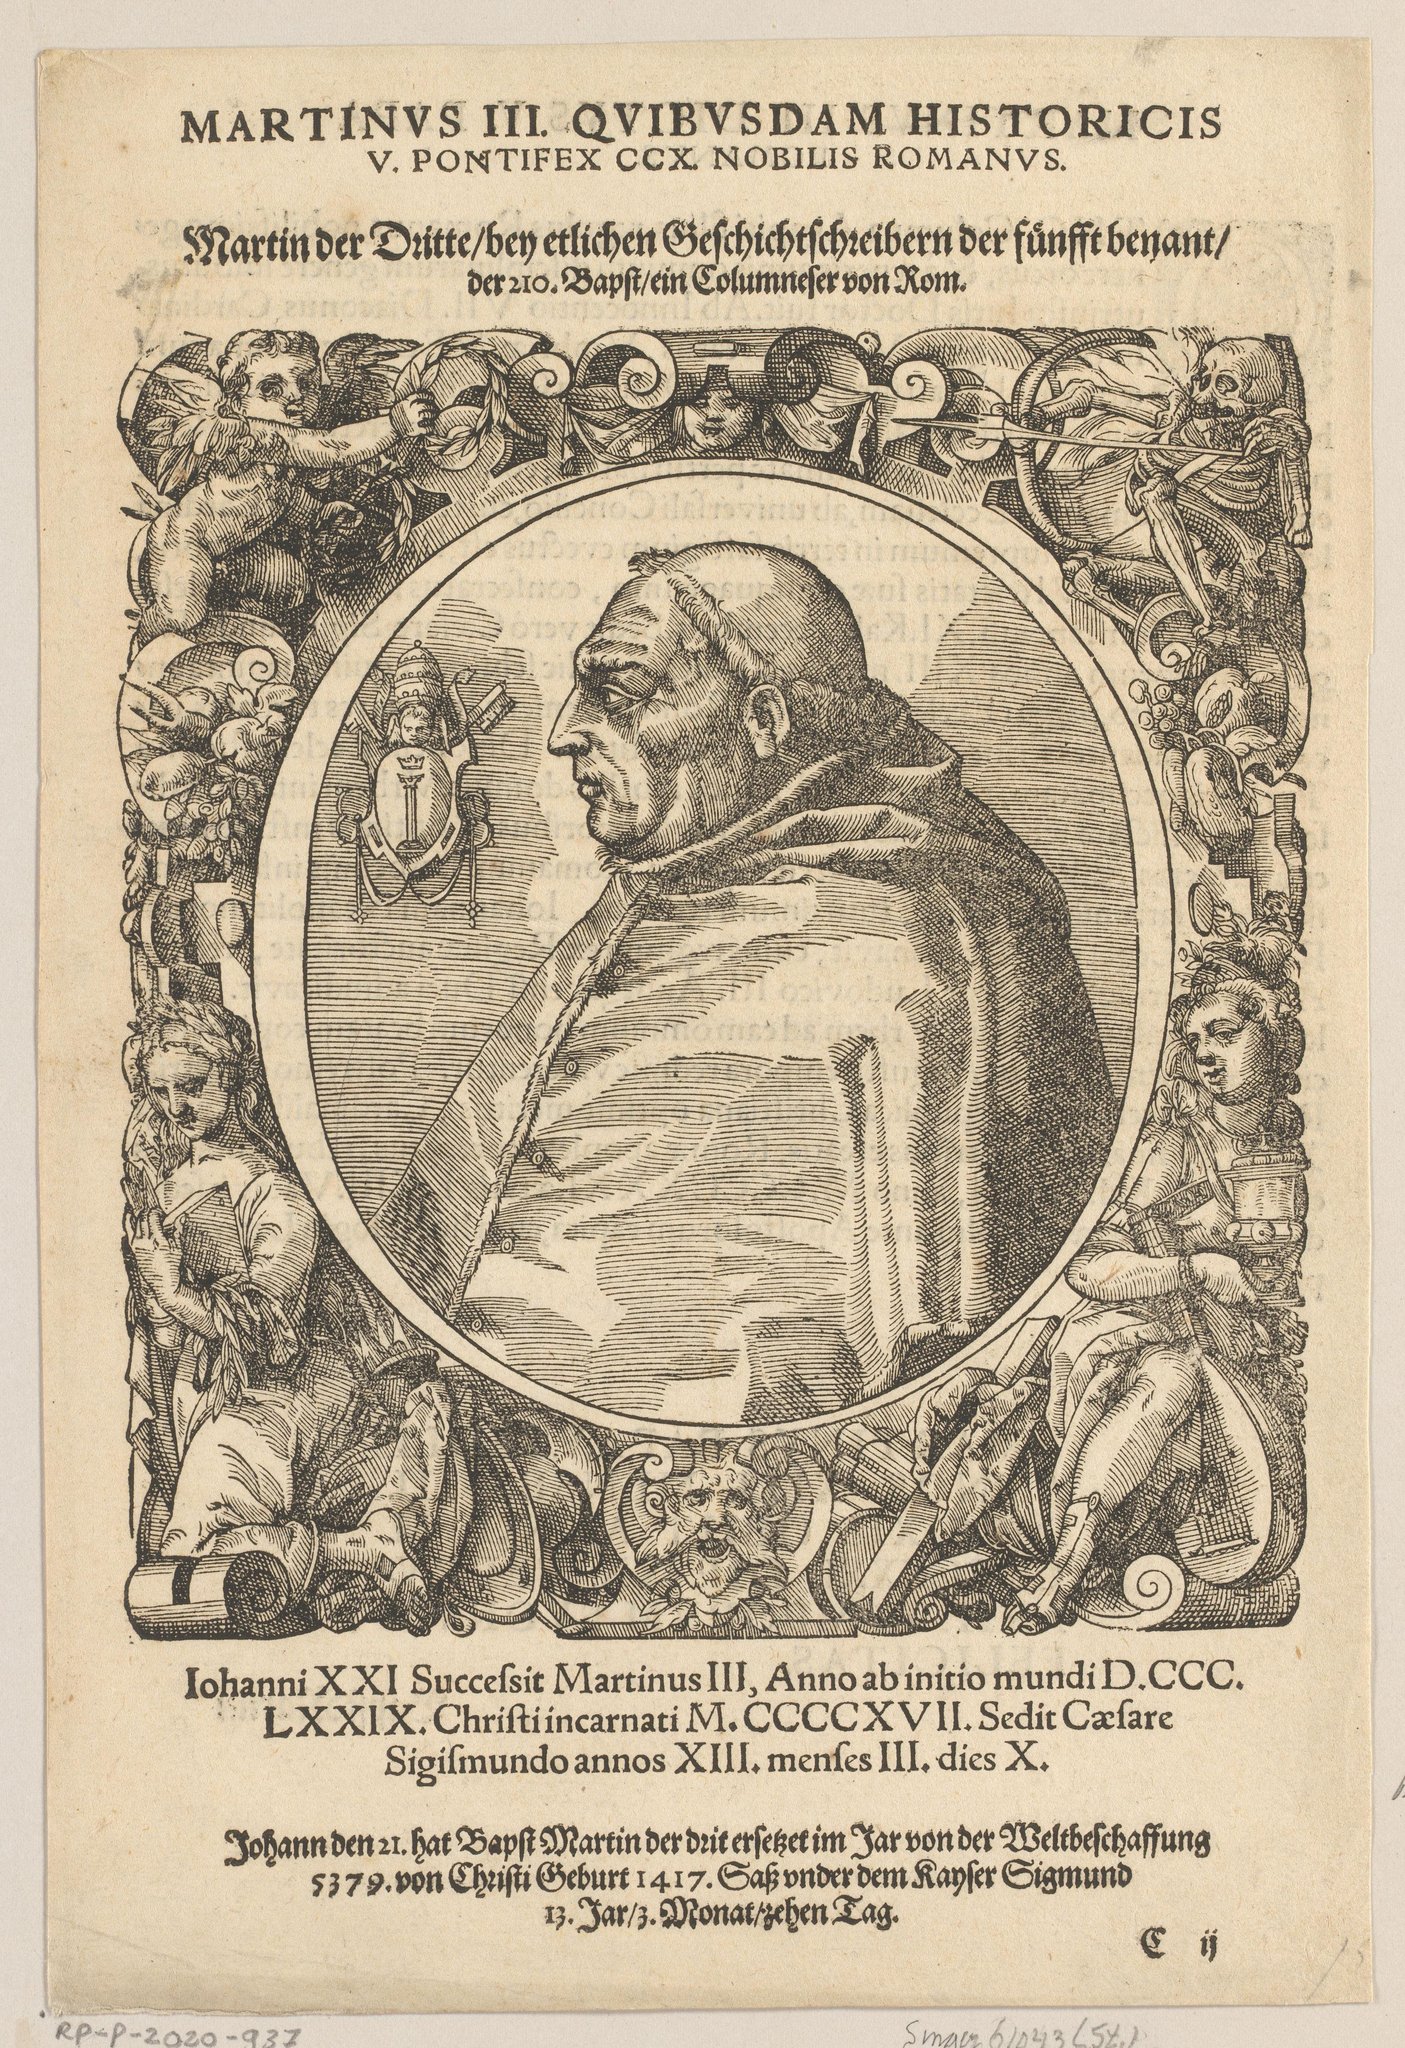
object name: book illustration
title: Portret van paus Martinus V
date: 1573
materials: paper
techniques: letterpress printing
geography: straatsburg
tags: rome, clergyman, historical persons, pope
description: Prent uit: Panvinio, Onofrio. Accurate effigies pontificum maximorum, numero XXVIII: ab anno Christi MCCCLXXVIII ad aetatum (...). Straatsburg: Bernhard Jobin, 1573.